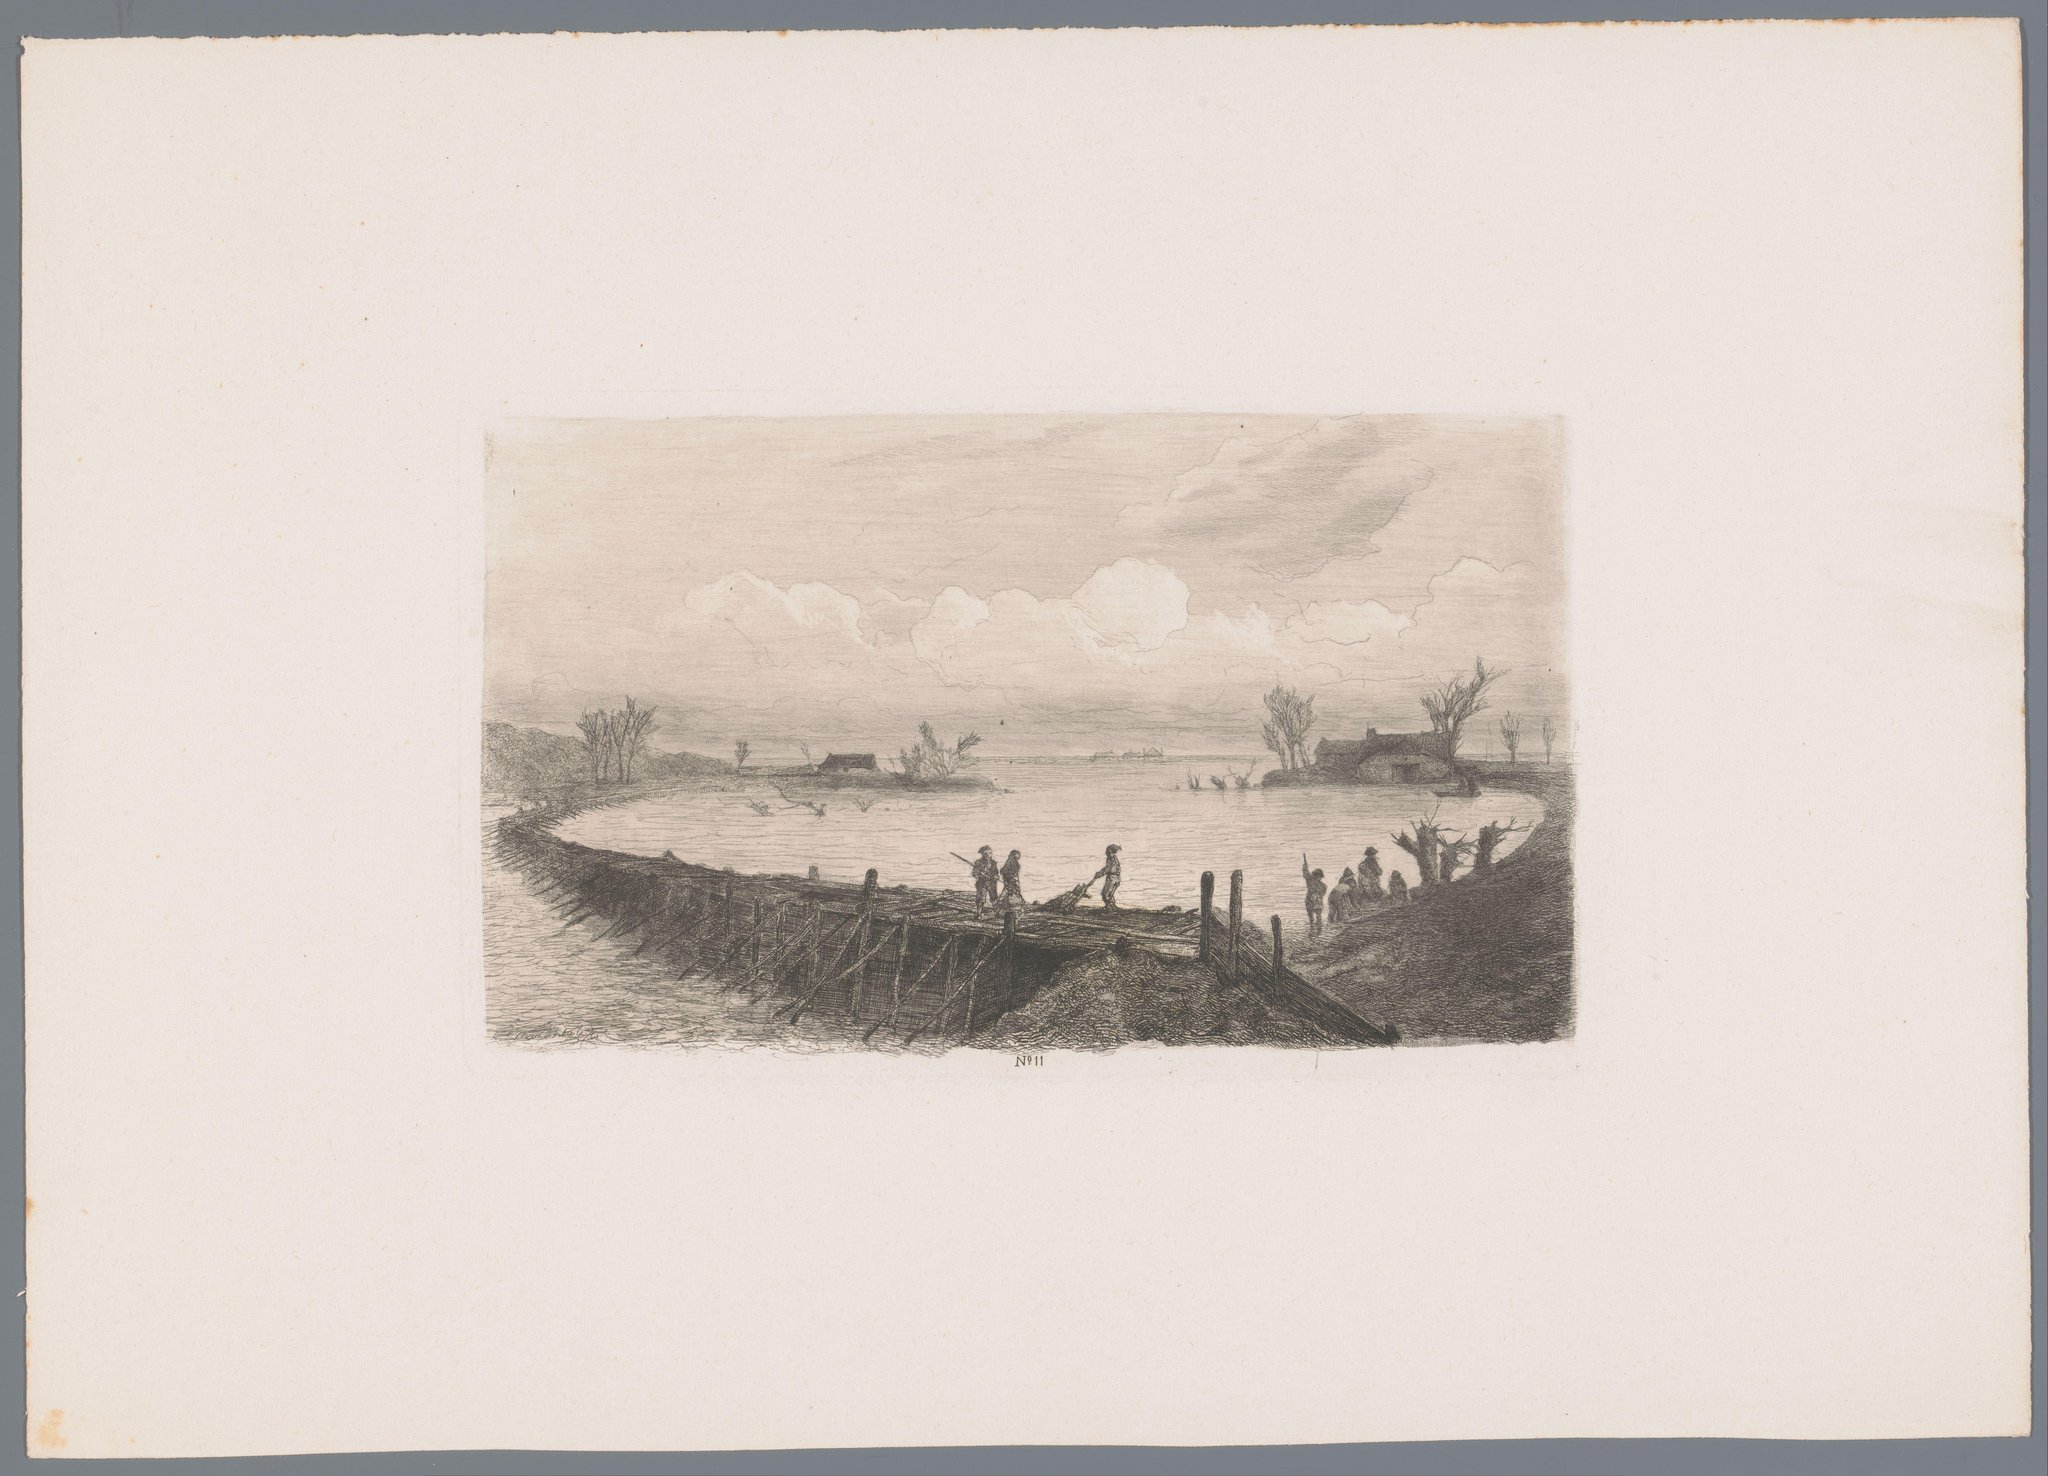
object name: print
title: De Waterramp van 1855. Geschetst in 24 afbeeldingen, naar de natuur geteekend en geëtst door leden der Maatschappij Arti et Amicitiae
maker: mari ten kate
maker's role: draughtsman, painter, print maker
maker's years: 1831-1910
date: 1855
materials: paper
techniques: etching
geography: netherlands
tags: dike-break, gelderland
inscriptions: collector's mark: Lugt 2228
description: Herstelwerkzaamheden bij de dijkdoorbraak bij het dorp Spees, 9 maart 1855. Onderdeel van de reeks van 24 prenten over de watersnood van maart 1855, door leden van het genootschap Arti et Amicitiae. Uitgave ten behoeve van de slachtoffers van de watersnood.